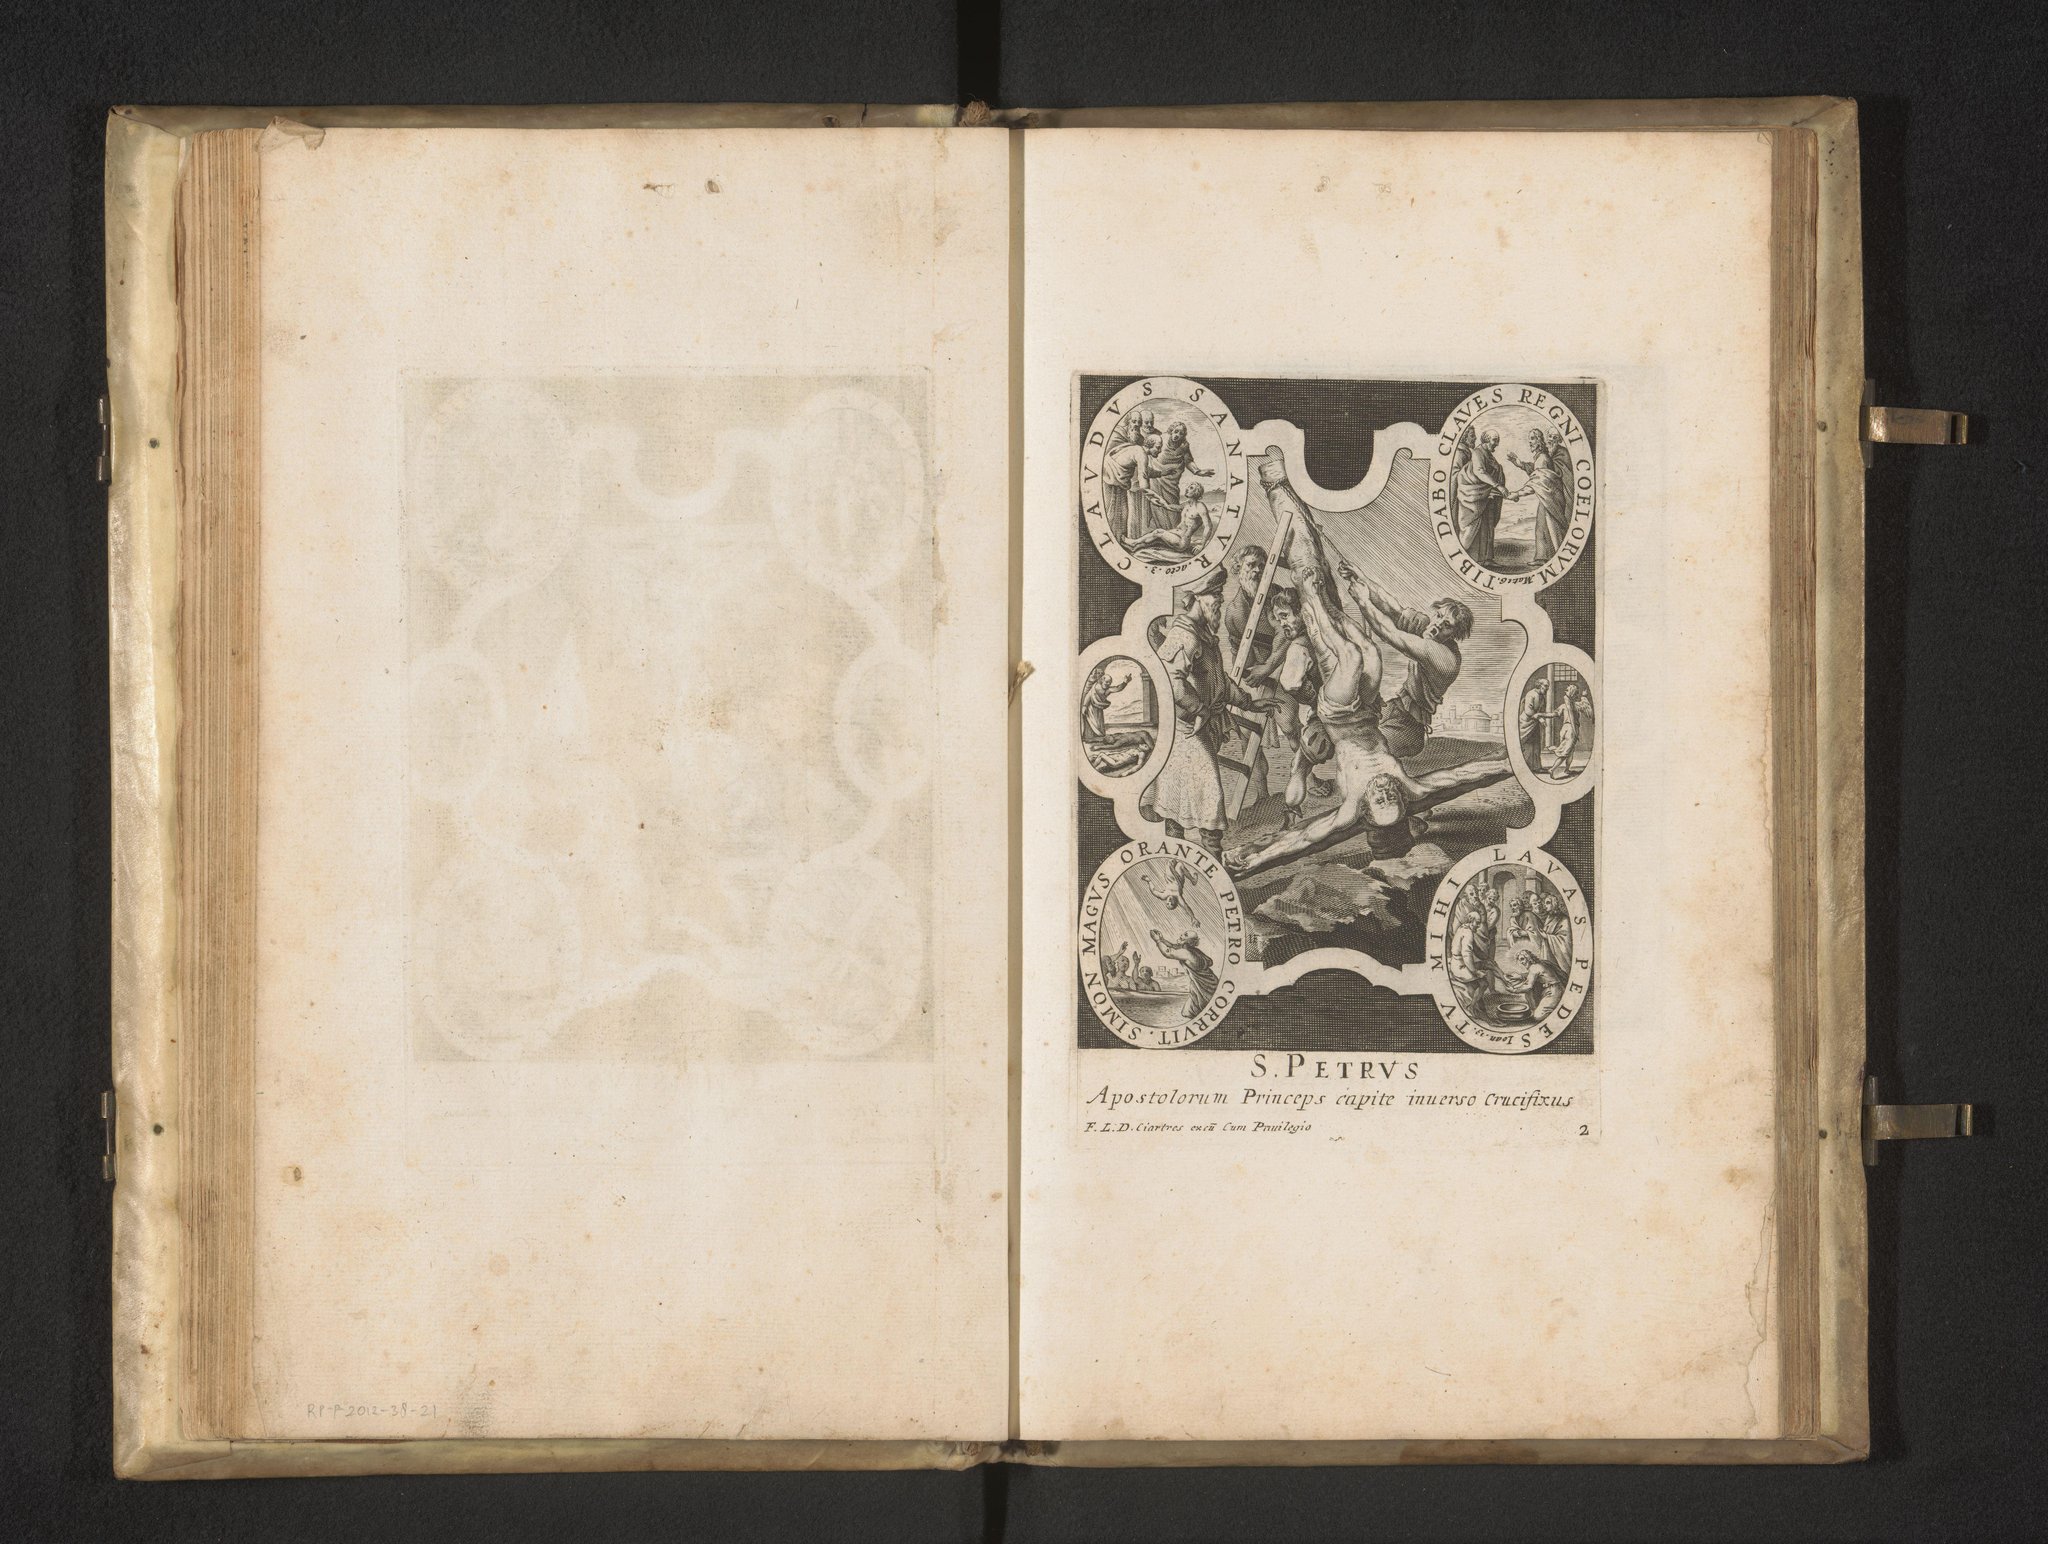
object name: print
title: Martelaarschap van Petrus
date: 1610-1647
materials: paper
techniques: engraving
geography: paris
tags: peter crucified upside down, the apostle peter, first bishop of rome; possible attributes: book, cock, (upturned) cross, (triple) crozier, fish, key, scroll, ship, tiara - martyrdom, suffering, misfortune, death of male saint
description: Martelaarschap van Petrus, in een kader met zes kleine scènes uit zijn leven. Onderdeel van een serie van twaalf voorstellingen van het martelaarschap van de apostelen. Onderdeel van een album met voornamelijk christelijke voorstellingen.